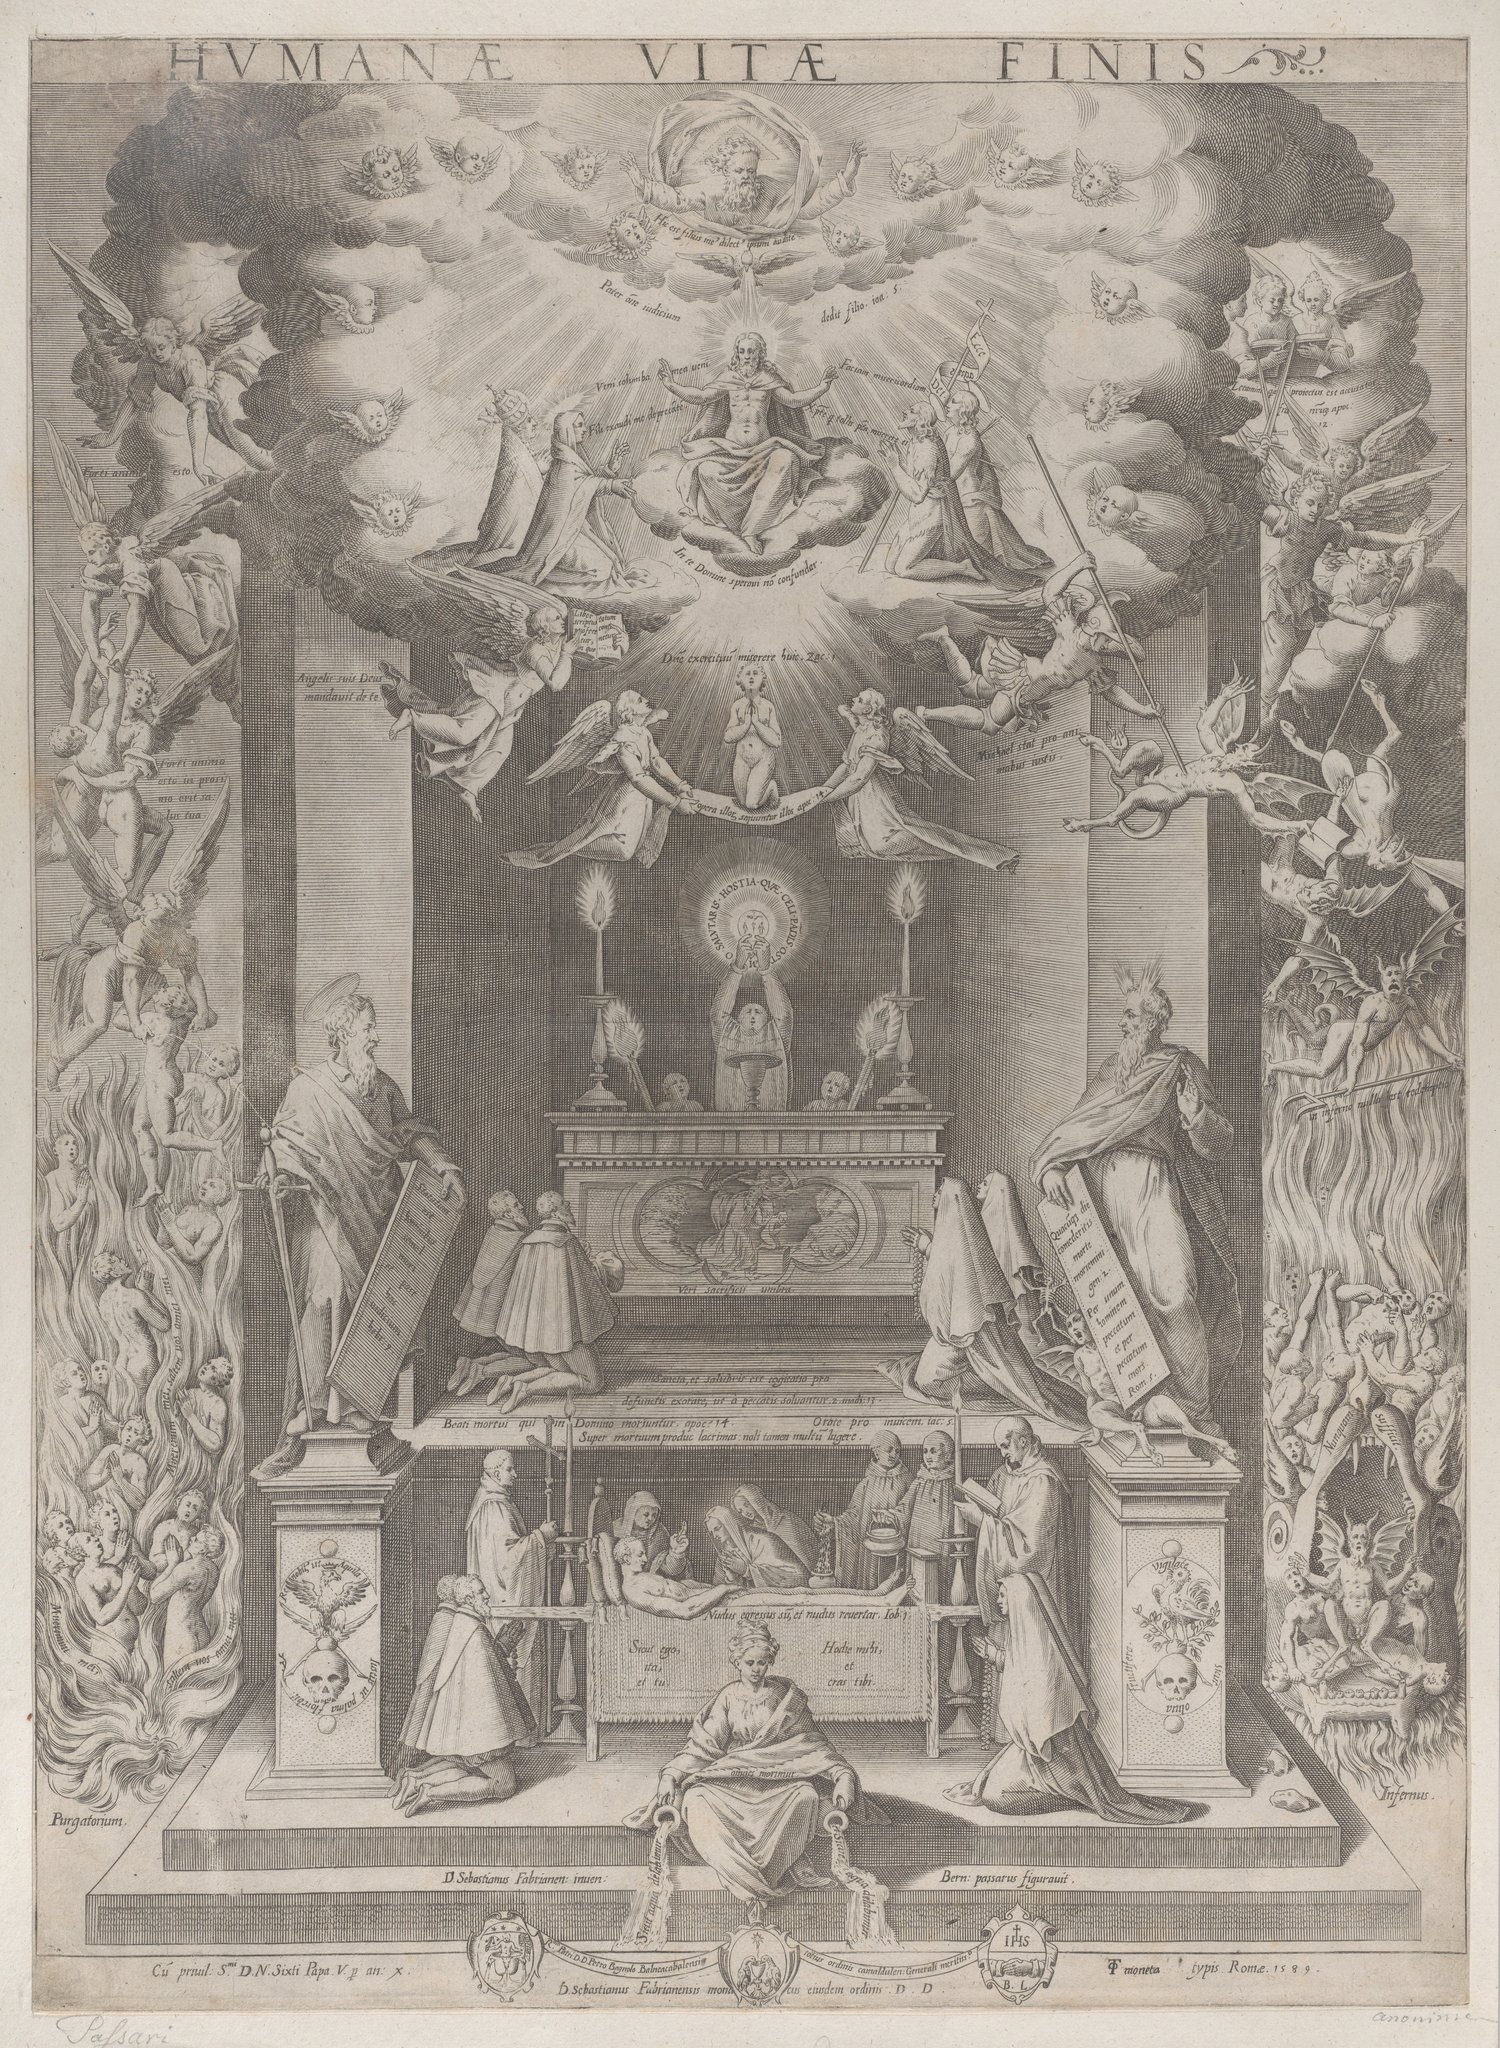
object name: print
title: Allegory of the end of man's life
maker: bernardino passeri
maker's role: artist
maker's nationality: italian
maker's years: 1577-1585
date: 1589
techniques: engraving